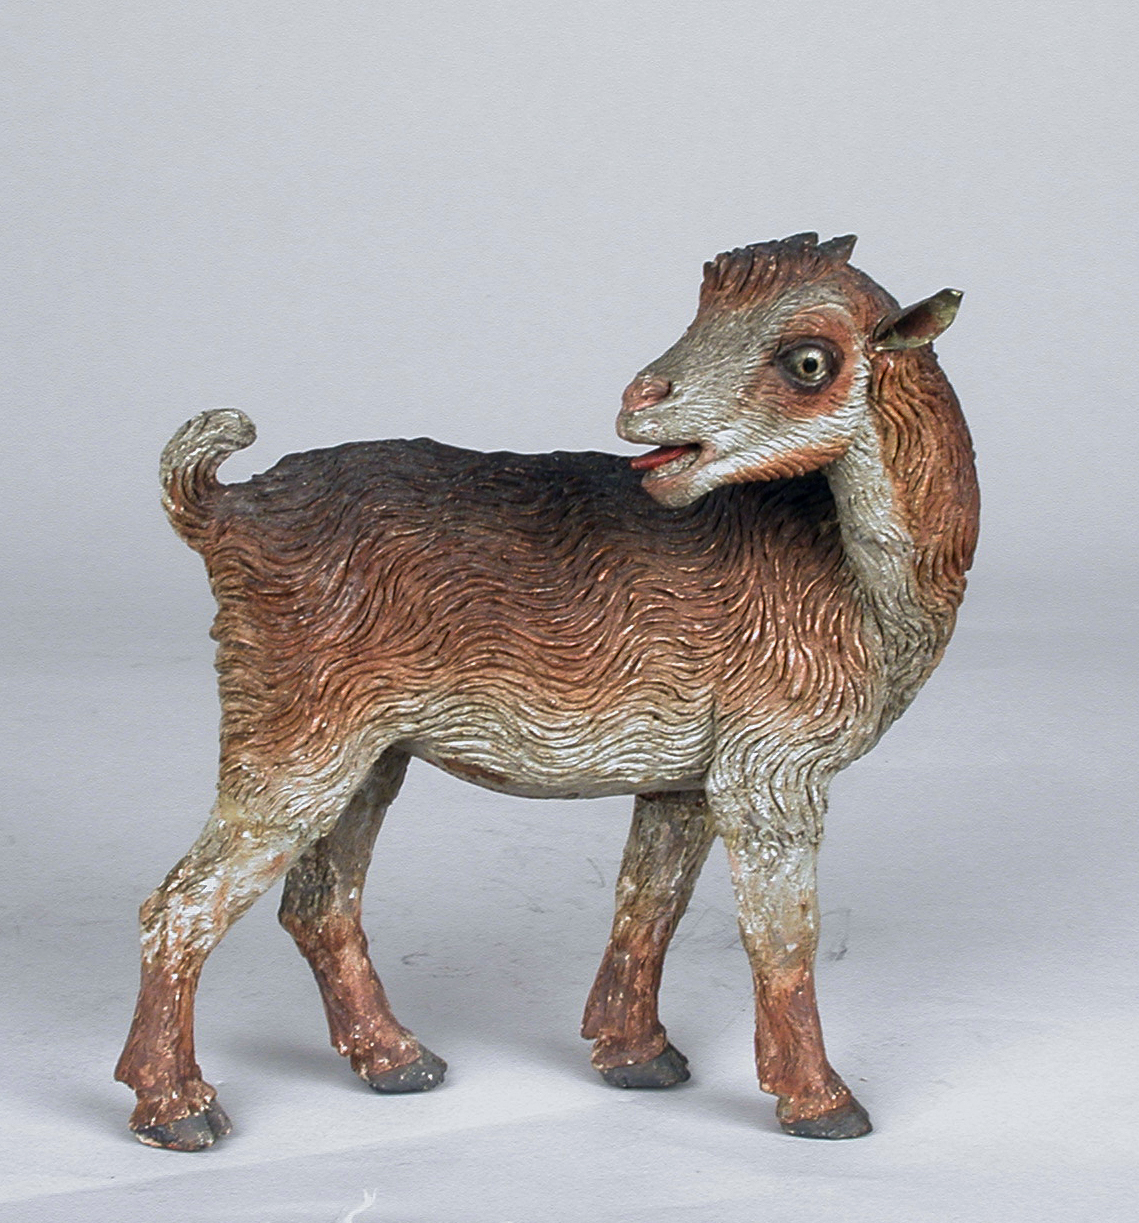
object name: crèche figure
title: Kid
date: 1751-1800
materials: metal, terracotta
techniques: polychrome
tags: goats